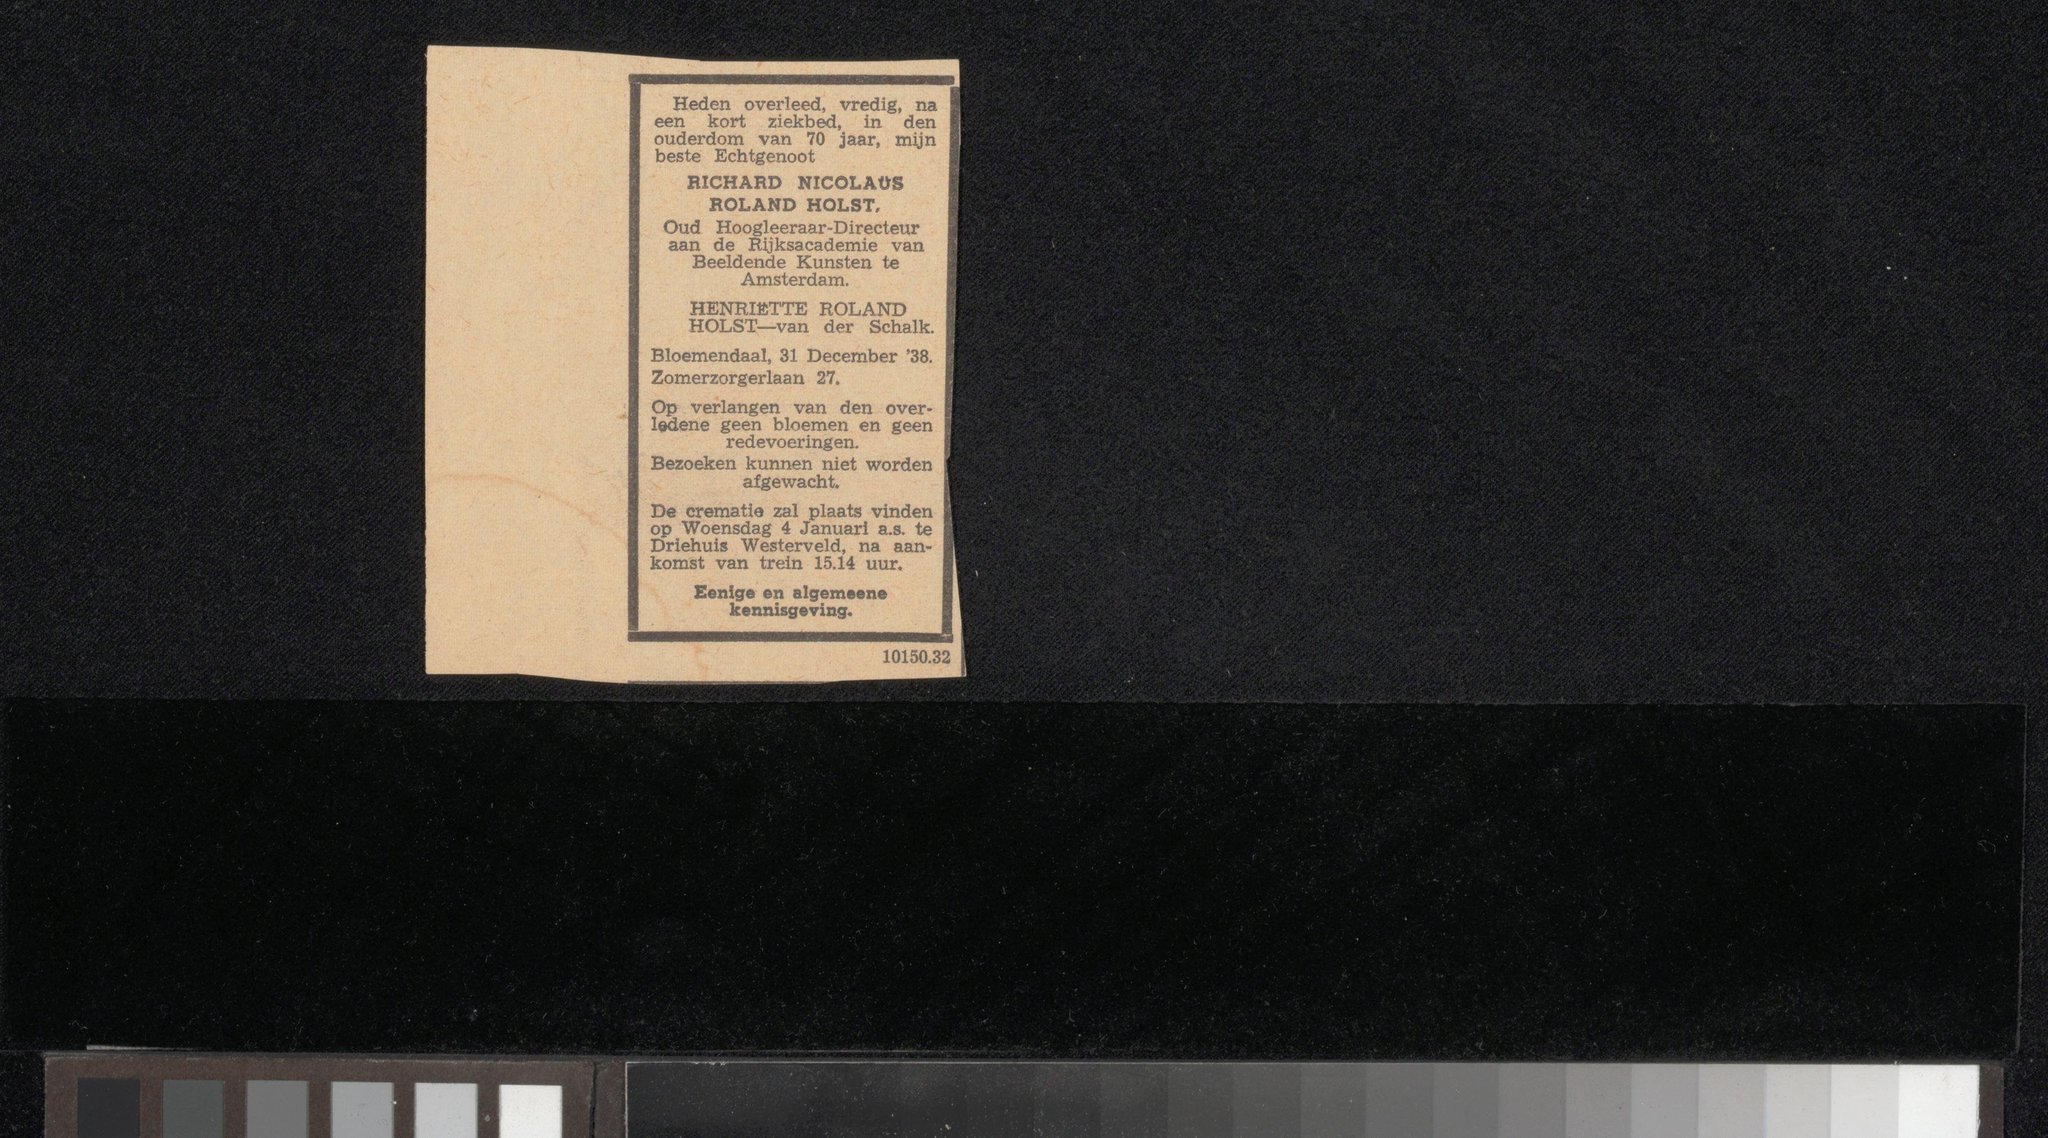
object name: newspaper clipping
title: Krantenknipsel betreffende Richard Roland Holst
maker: Anonymous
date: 1938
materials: paper, ink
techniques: printing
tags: richard nicolaüs roland holst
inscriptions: collector's mark: ‘RPK’